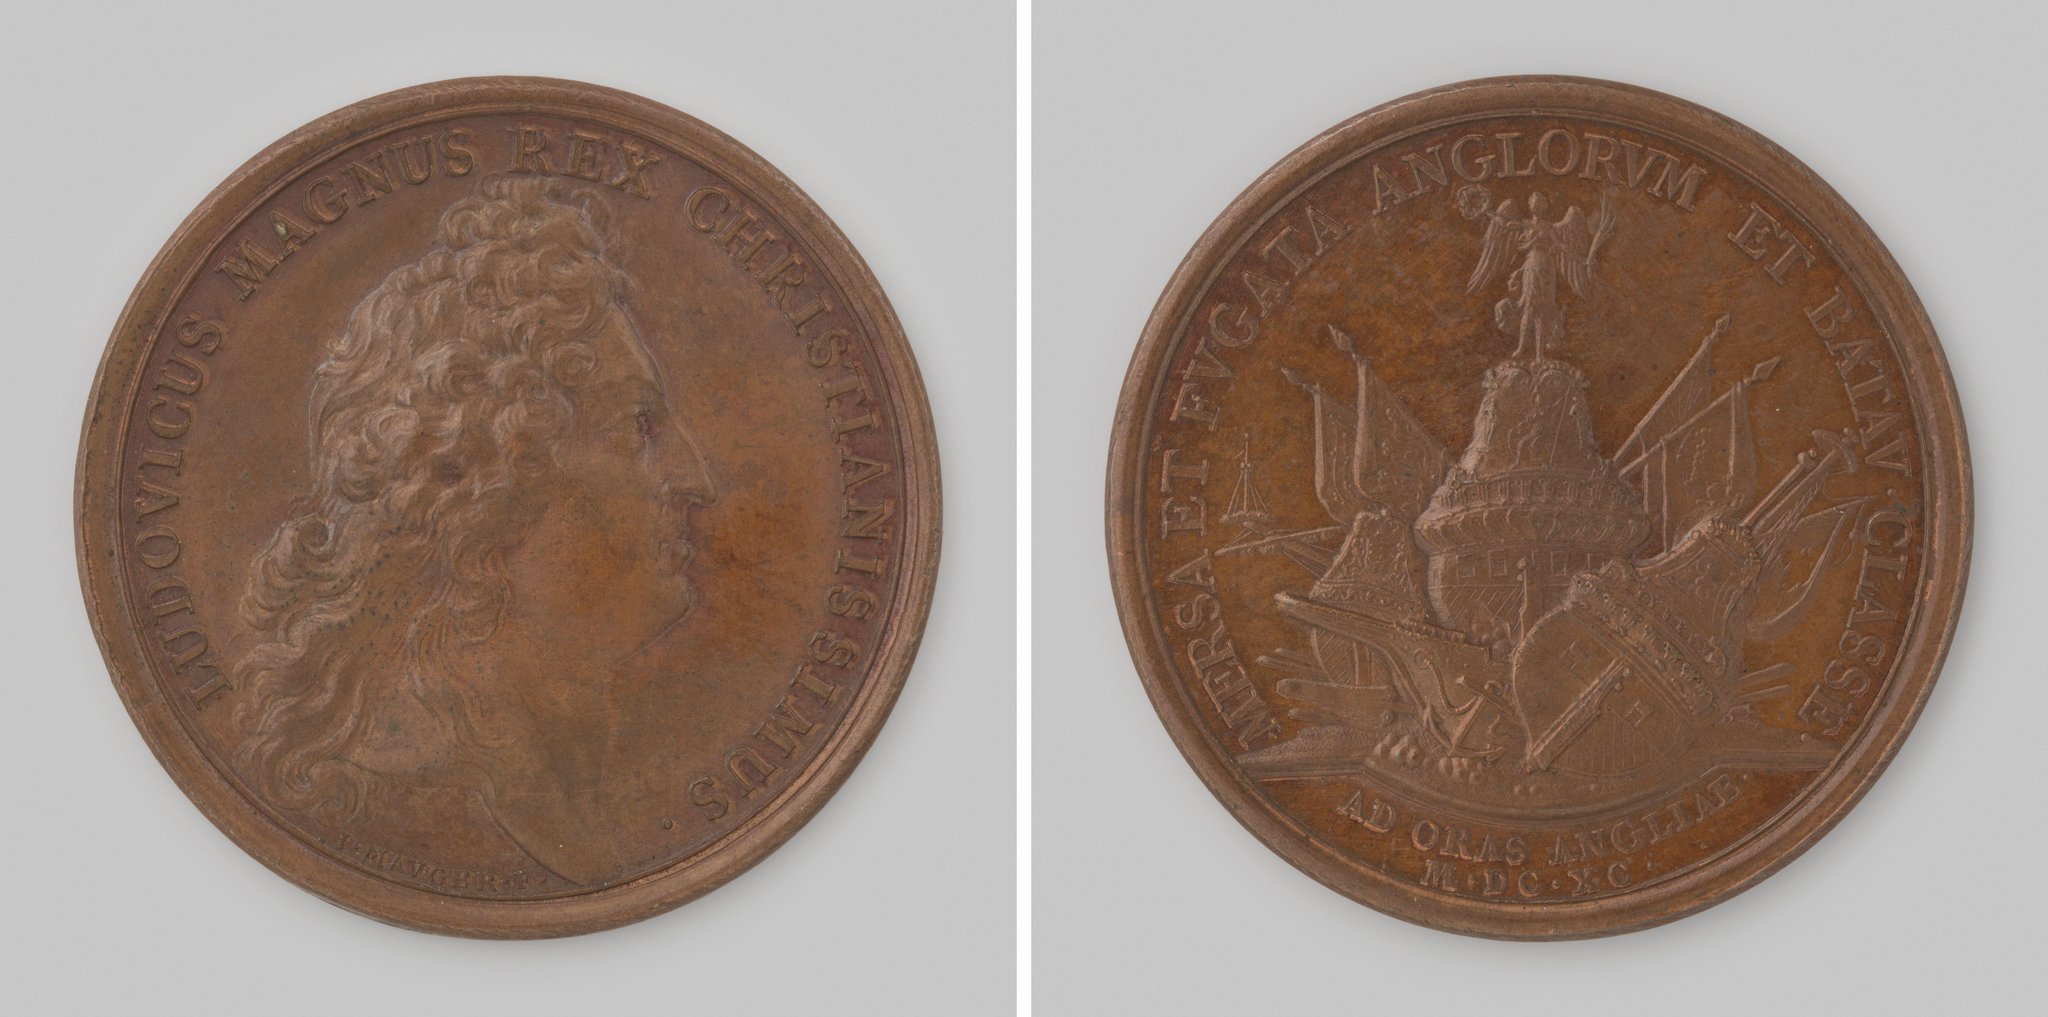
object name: history medal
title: De Engelse en Nederlandse vloot door de Franse vernield 1690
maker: jean mauger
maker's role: medailleur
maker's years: 1648-1722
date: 1690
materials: copper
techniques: striking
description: Koperen penning,op de voorzijde het portret van Lodewijk XIV met omschrift, op de keerzijde Victoria op een stapel oorlogsschepen, met omschrift.